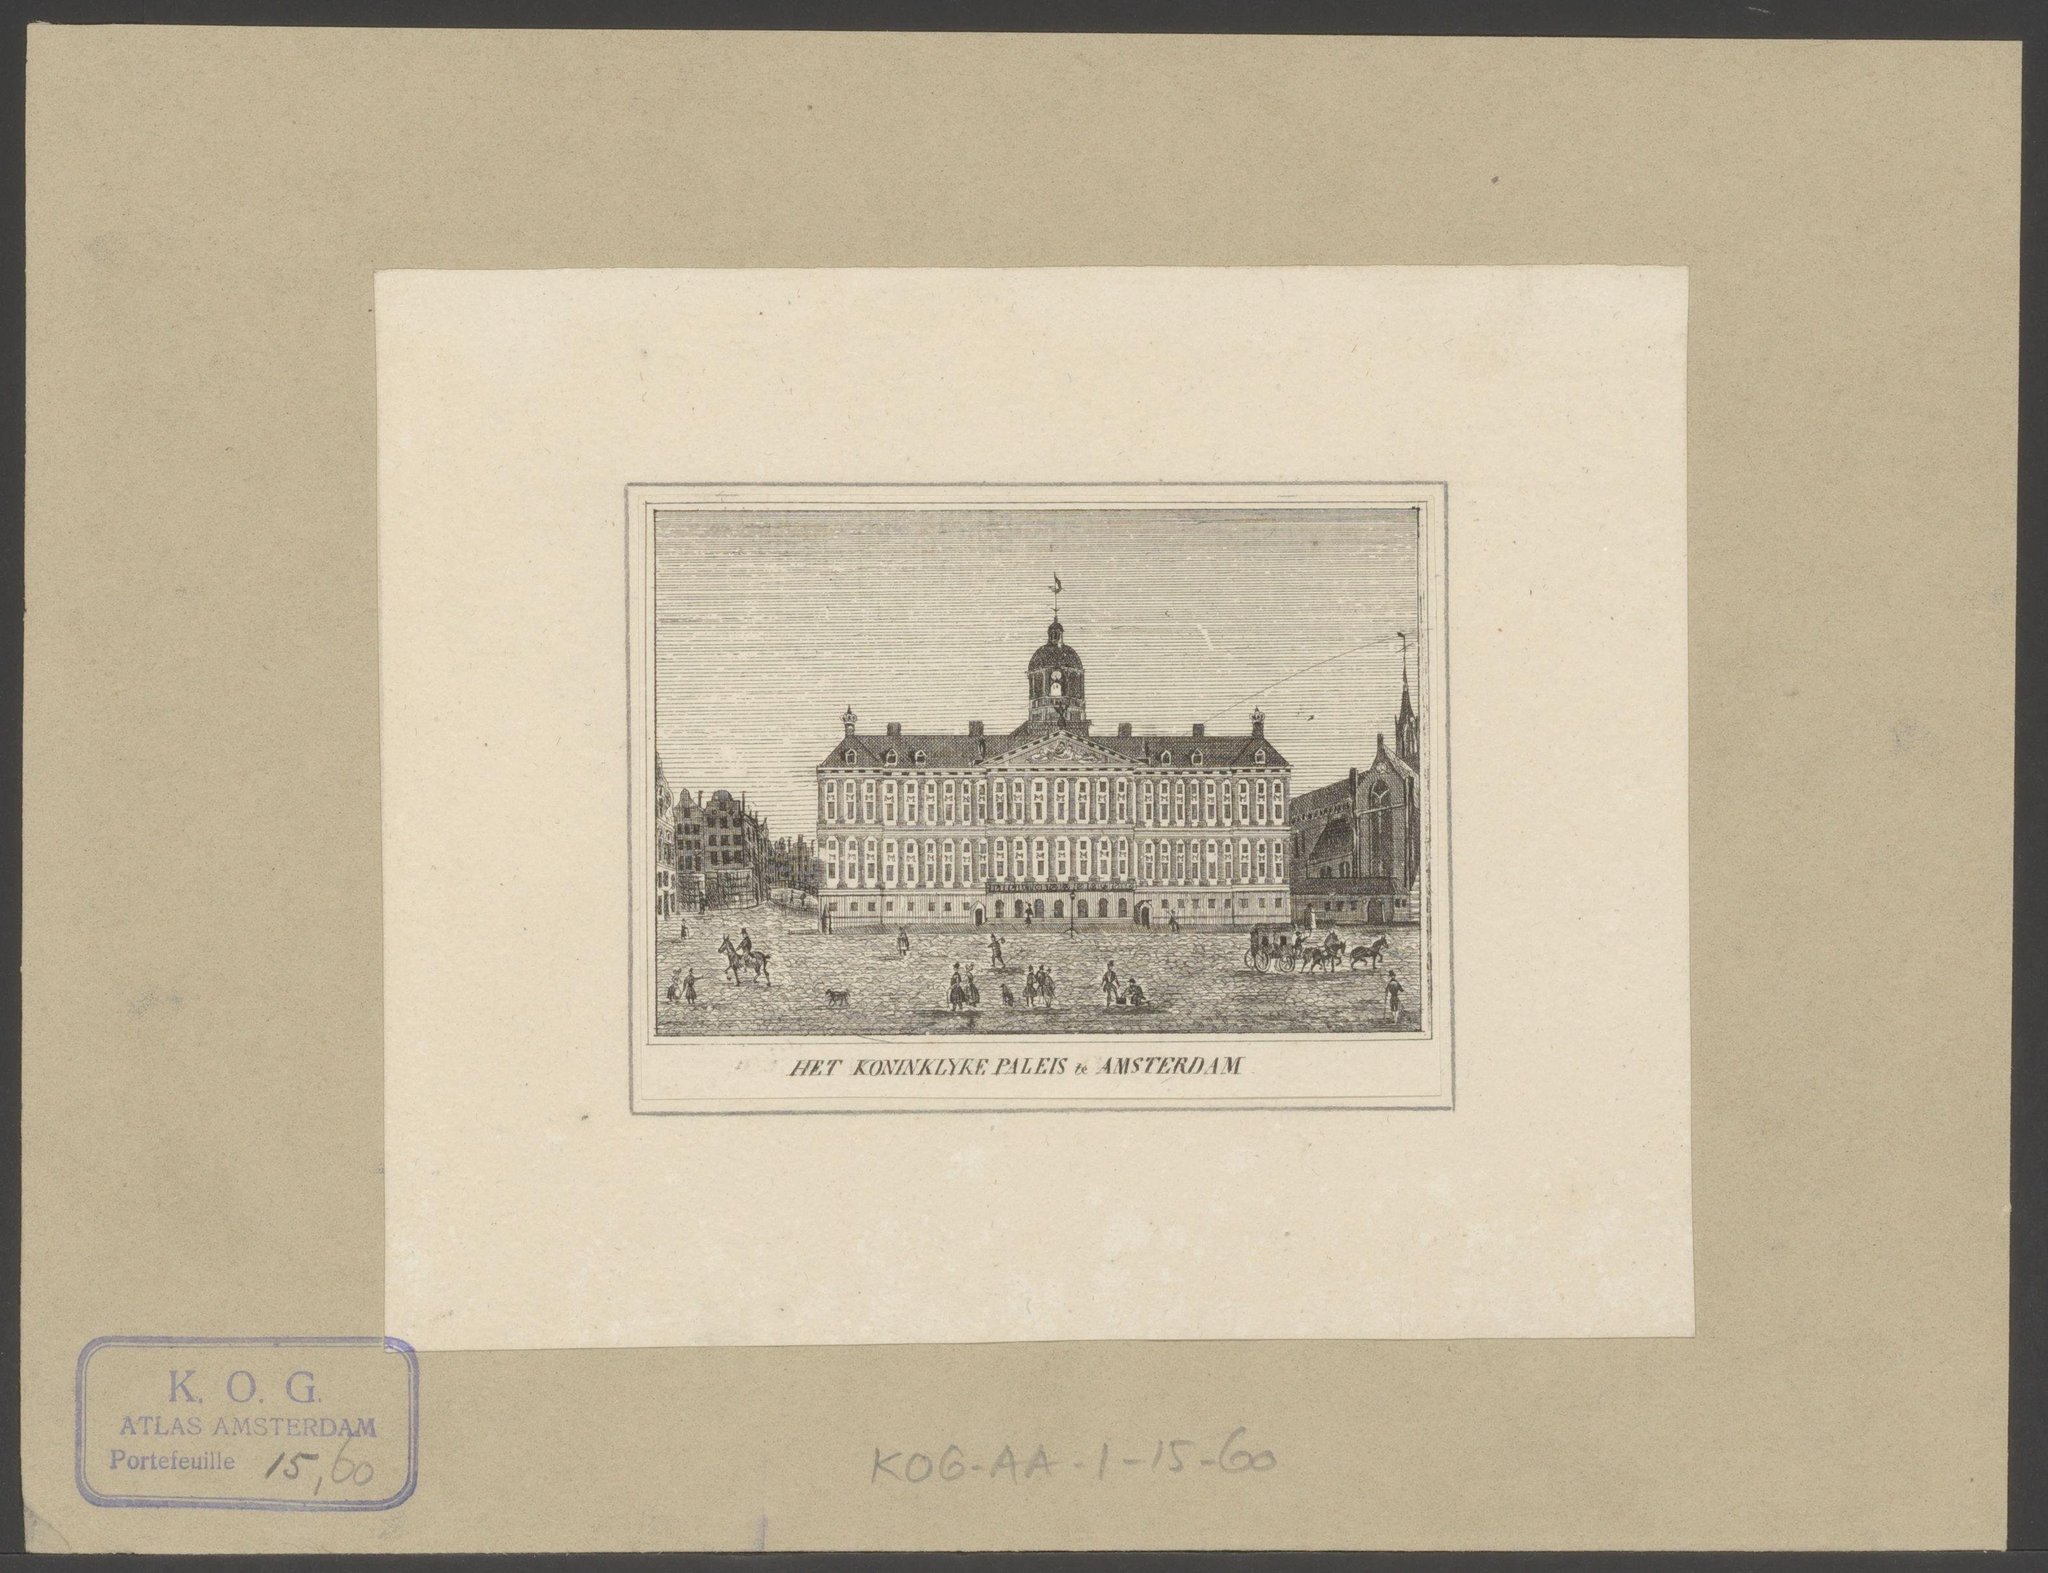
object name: print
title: Gezicht op het Paleis op de Dam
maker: Anonymous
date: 1800-1899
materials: paper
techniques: etching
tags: square, place, circus, etc., city-view in general; 'veduta', townhall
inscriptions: collector's mark: ‘15,60’ Lugt 1641b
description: Onderwerpsrubriek binnen de Atlas Amsterdam: Nieuwe Stadhuis, als Paleis, op de Dam, van Buiten.